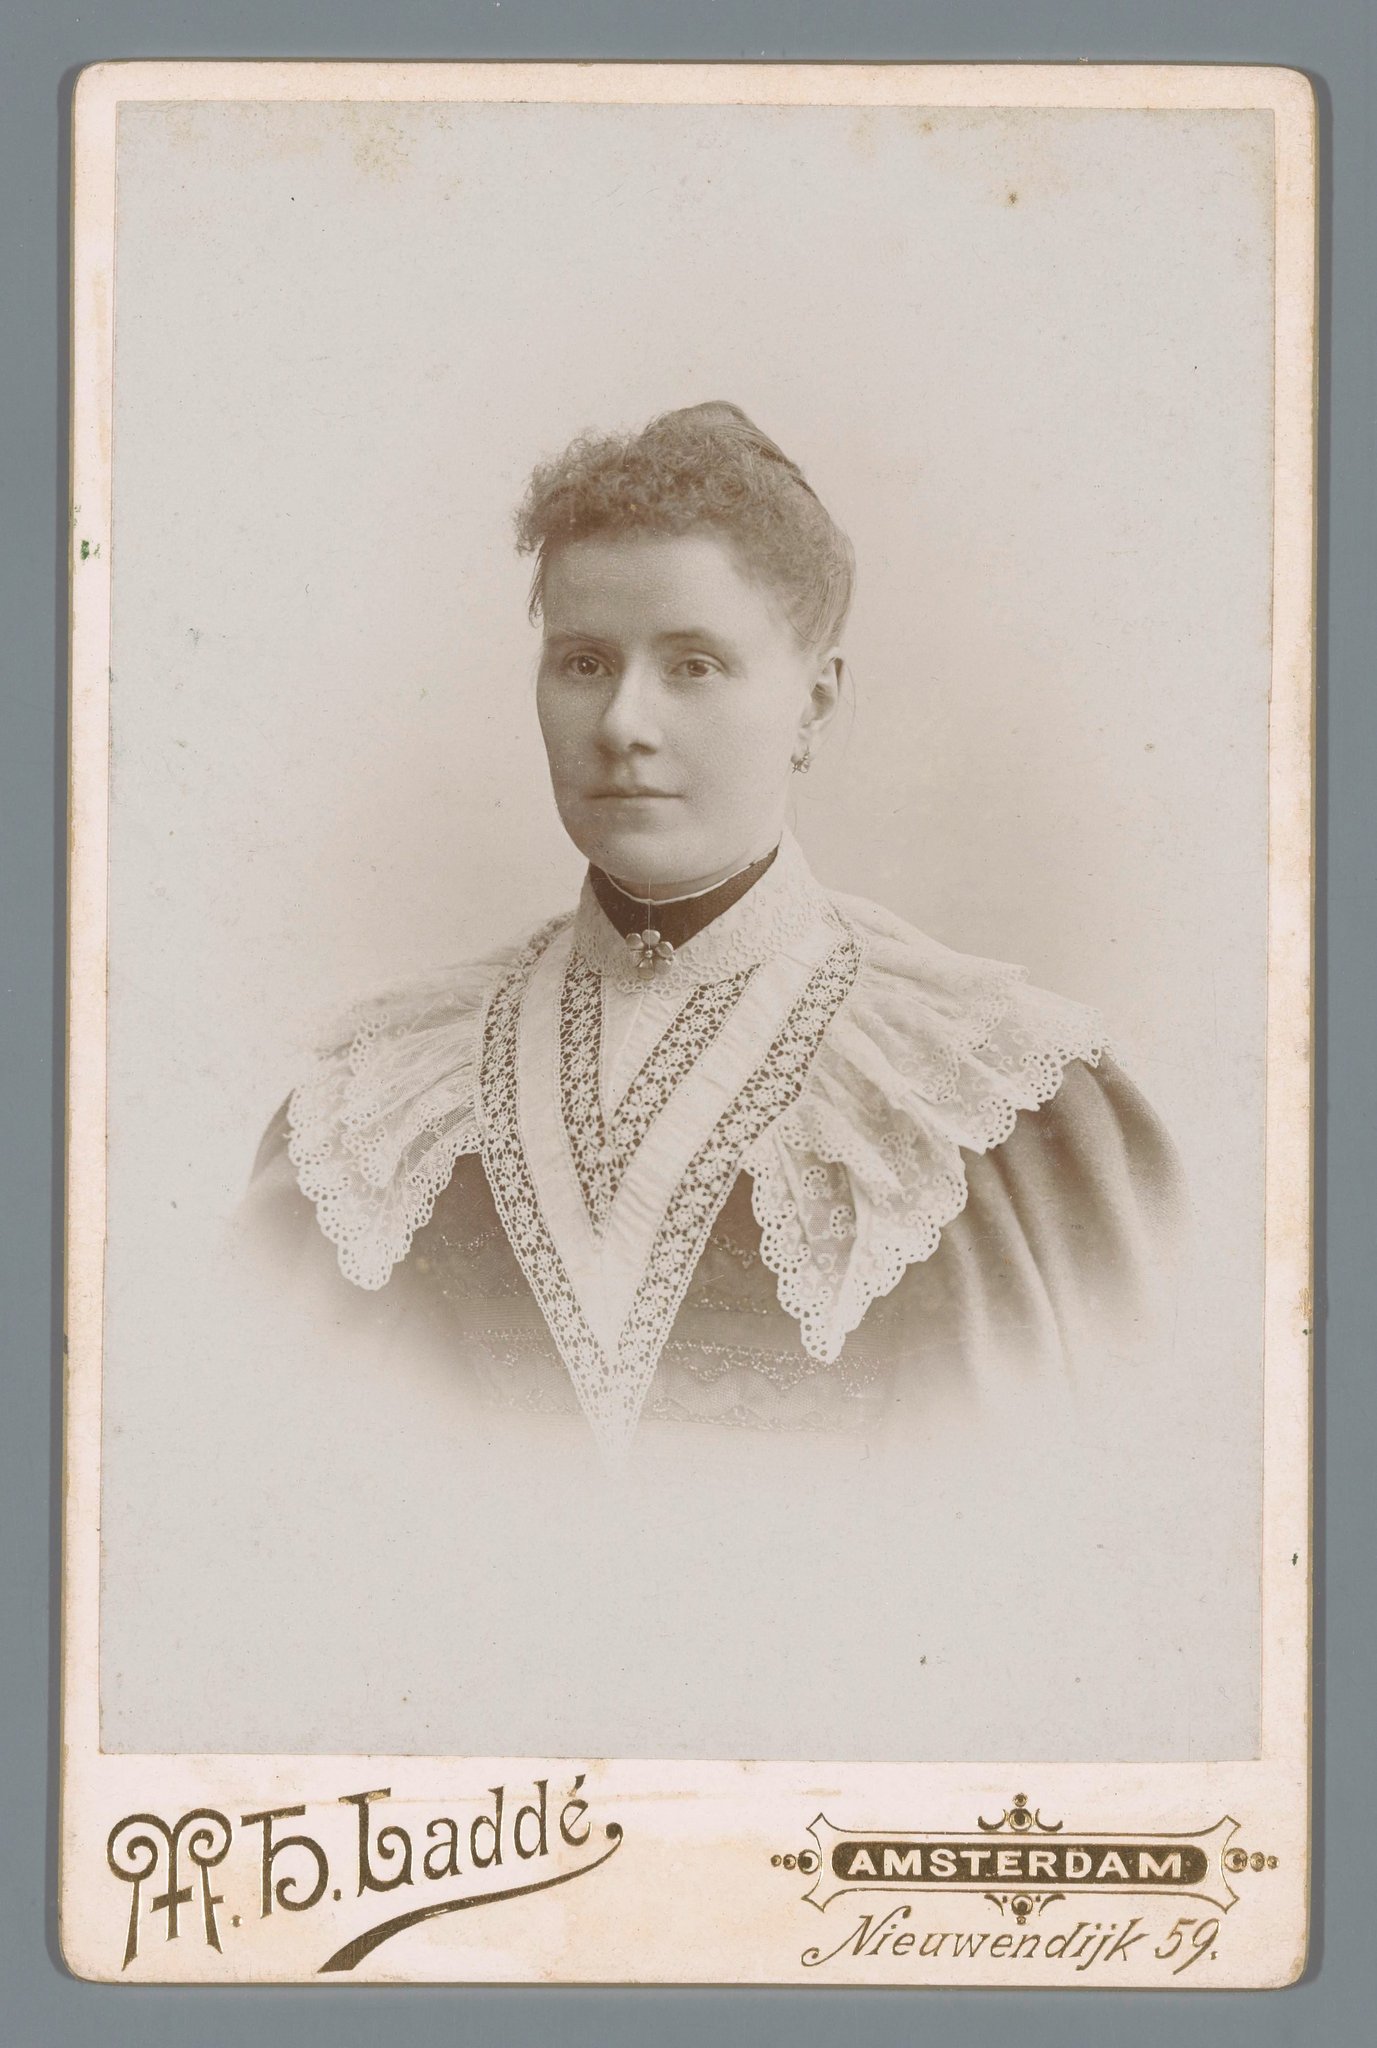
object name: cabinet photograph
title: Portret van een onbekende vrouw in klederdracht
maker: machiel hendricus laddé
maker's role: fotograaf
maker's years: 1866-1932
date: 1892-1906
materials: cardboard, photographic support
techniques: collodion silver print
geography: amsterdam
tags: adult woman, folk costume, regional costume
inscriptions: name: ‘Photographie Artistique M.H. Laddé Nieuwendijk 59 boven de Firma Merkelbach & Co Amsterdam. (...)’